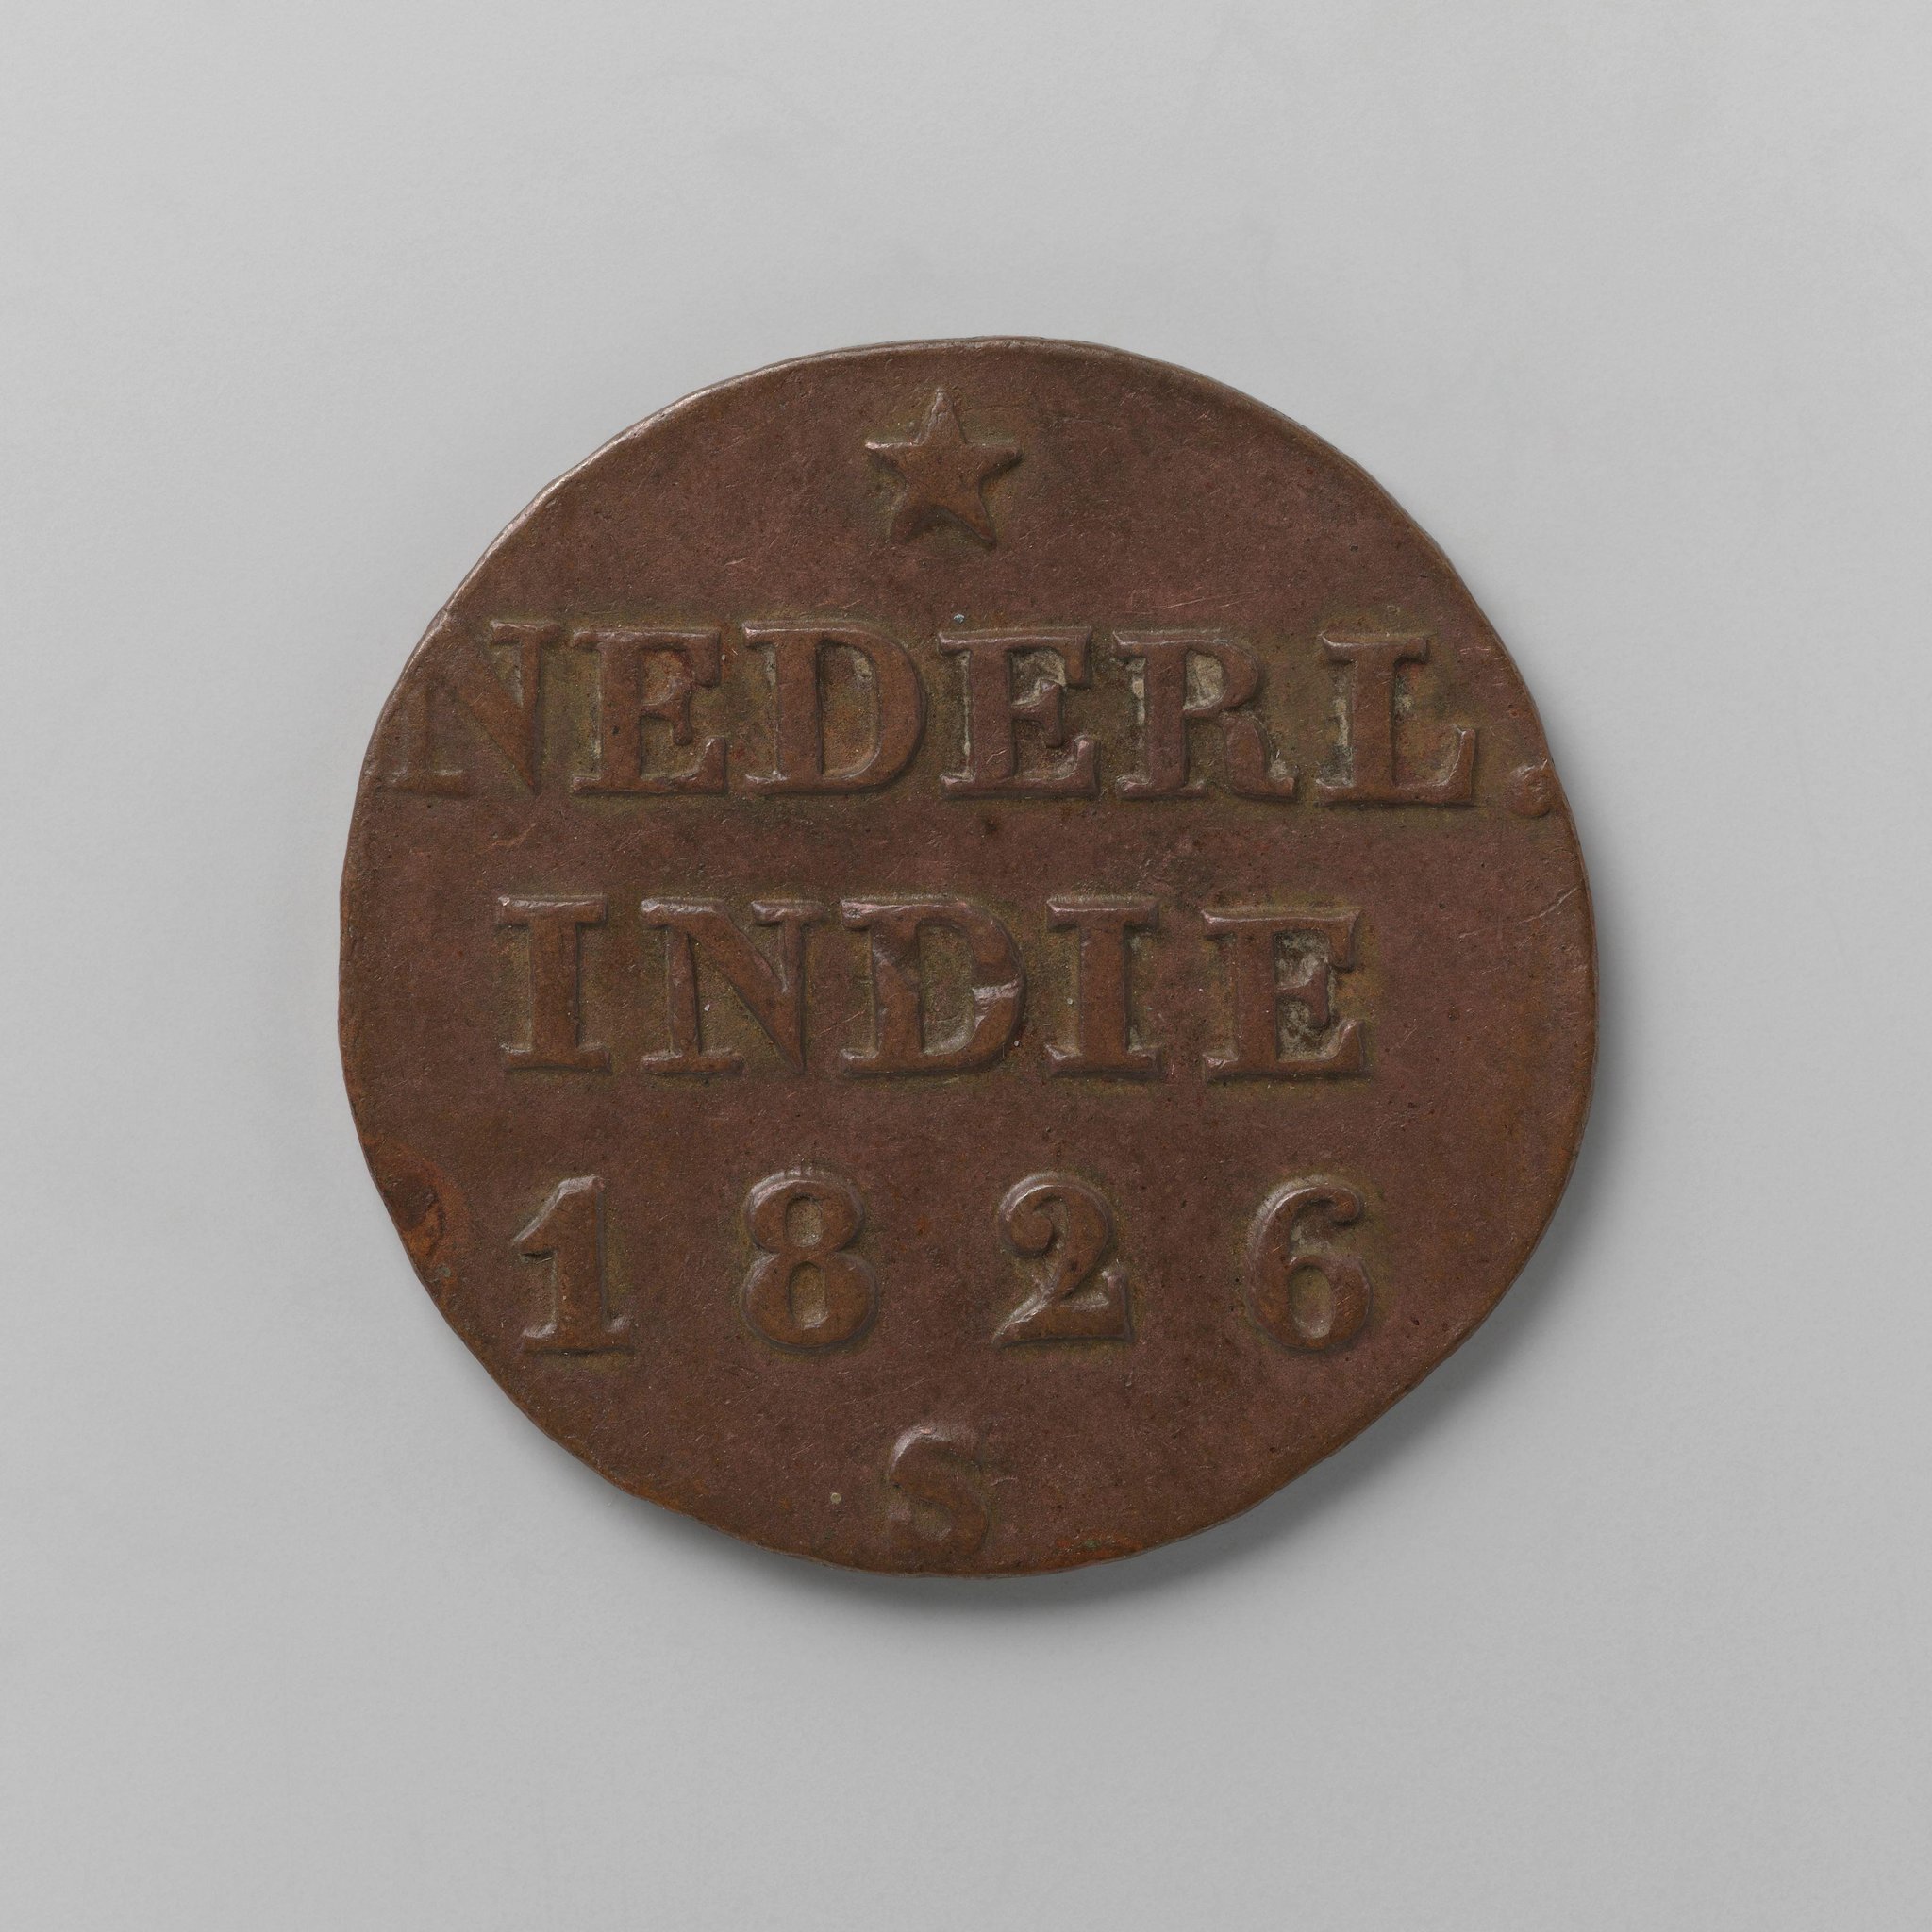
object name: coin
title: Nederlands Indië,1/4 stuiver,1826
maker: william i of the netherlands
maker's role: koning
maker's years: 1772-1843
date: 1826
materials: copper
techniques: striking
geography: utrecht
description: Koperen munt. Voorzijde: tussen waarde-aanduiding 1/4 St. gekroond rijkswapenschild. Keerzijde: tweeregelig opschrift, waarboven muntteken en waaronder jaartal. Daaronder muntmeesterteken S [=Suermondt]. Gladde rand.